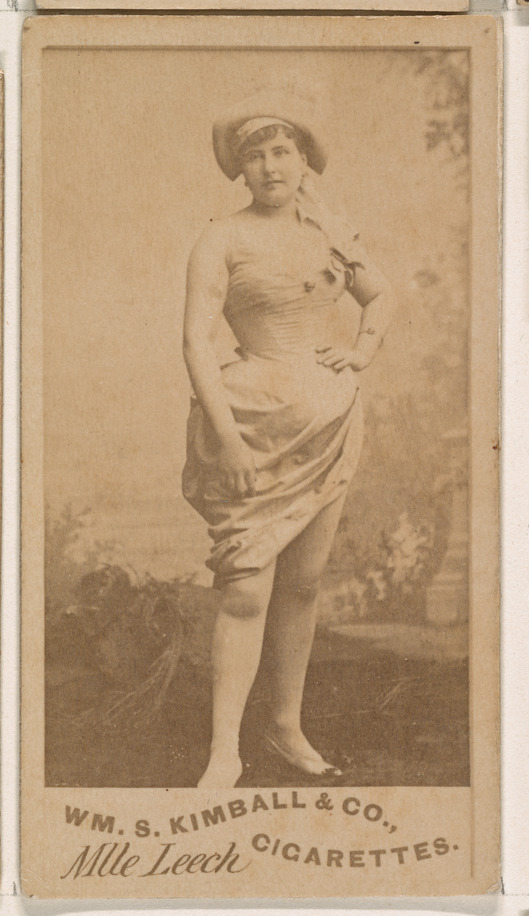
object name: photograph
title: Mlle. Leech, from the Actresses series (N203) issued by Wm. S. Kimball & Co.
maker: william s. kimball & company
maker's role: publisher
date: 1889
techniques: color lithograph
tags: portraits,women,actresses